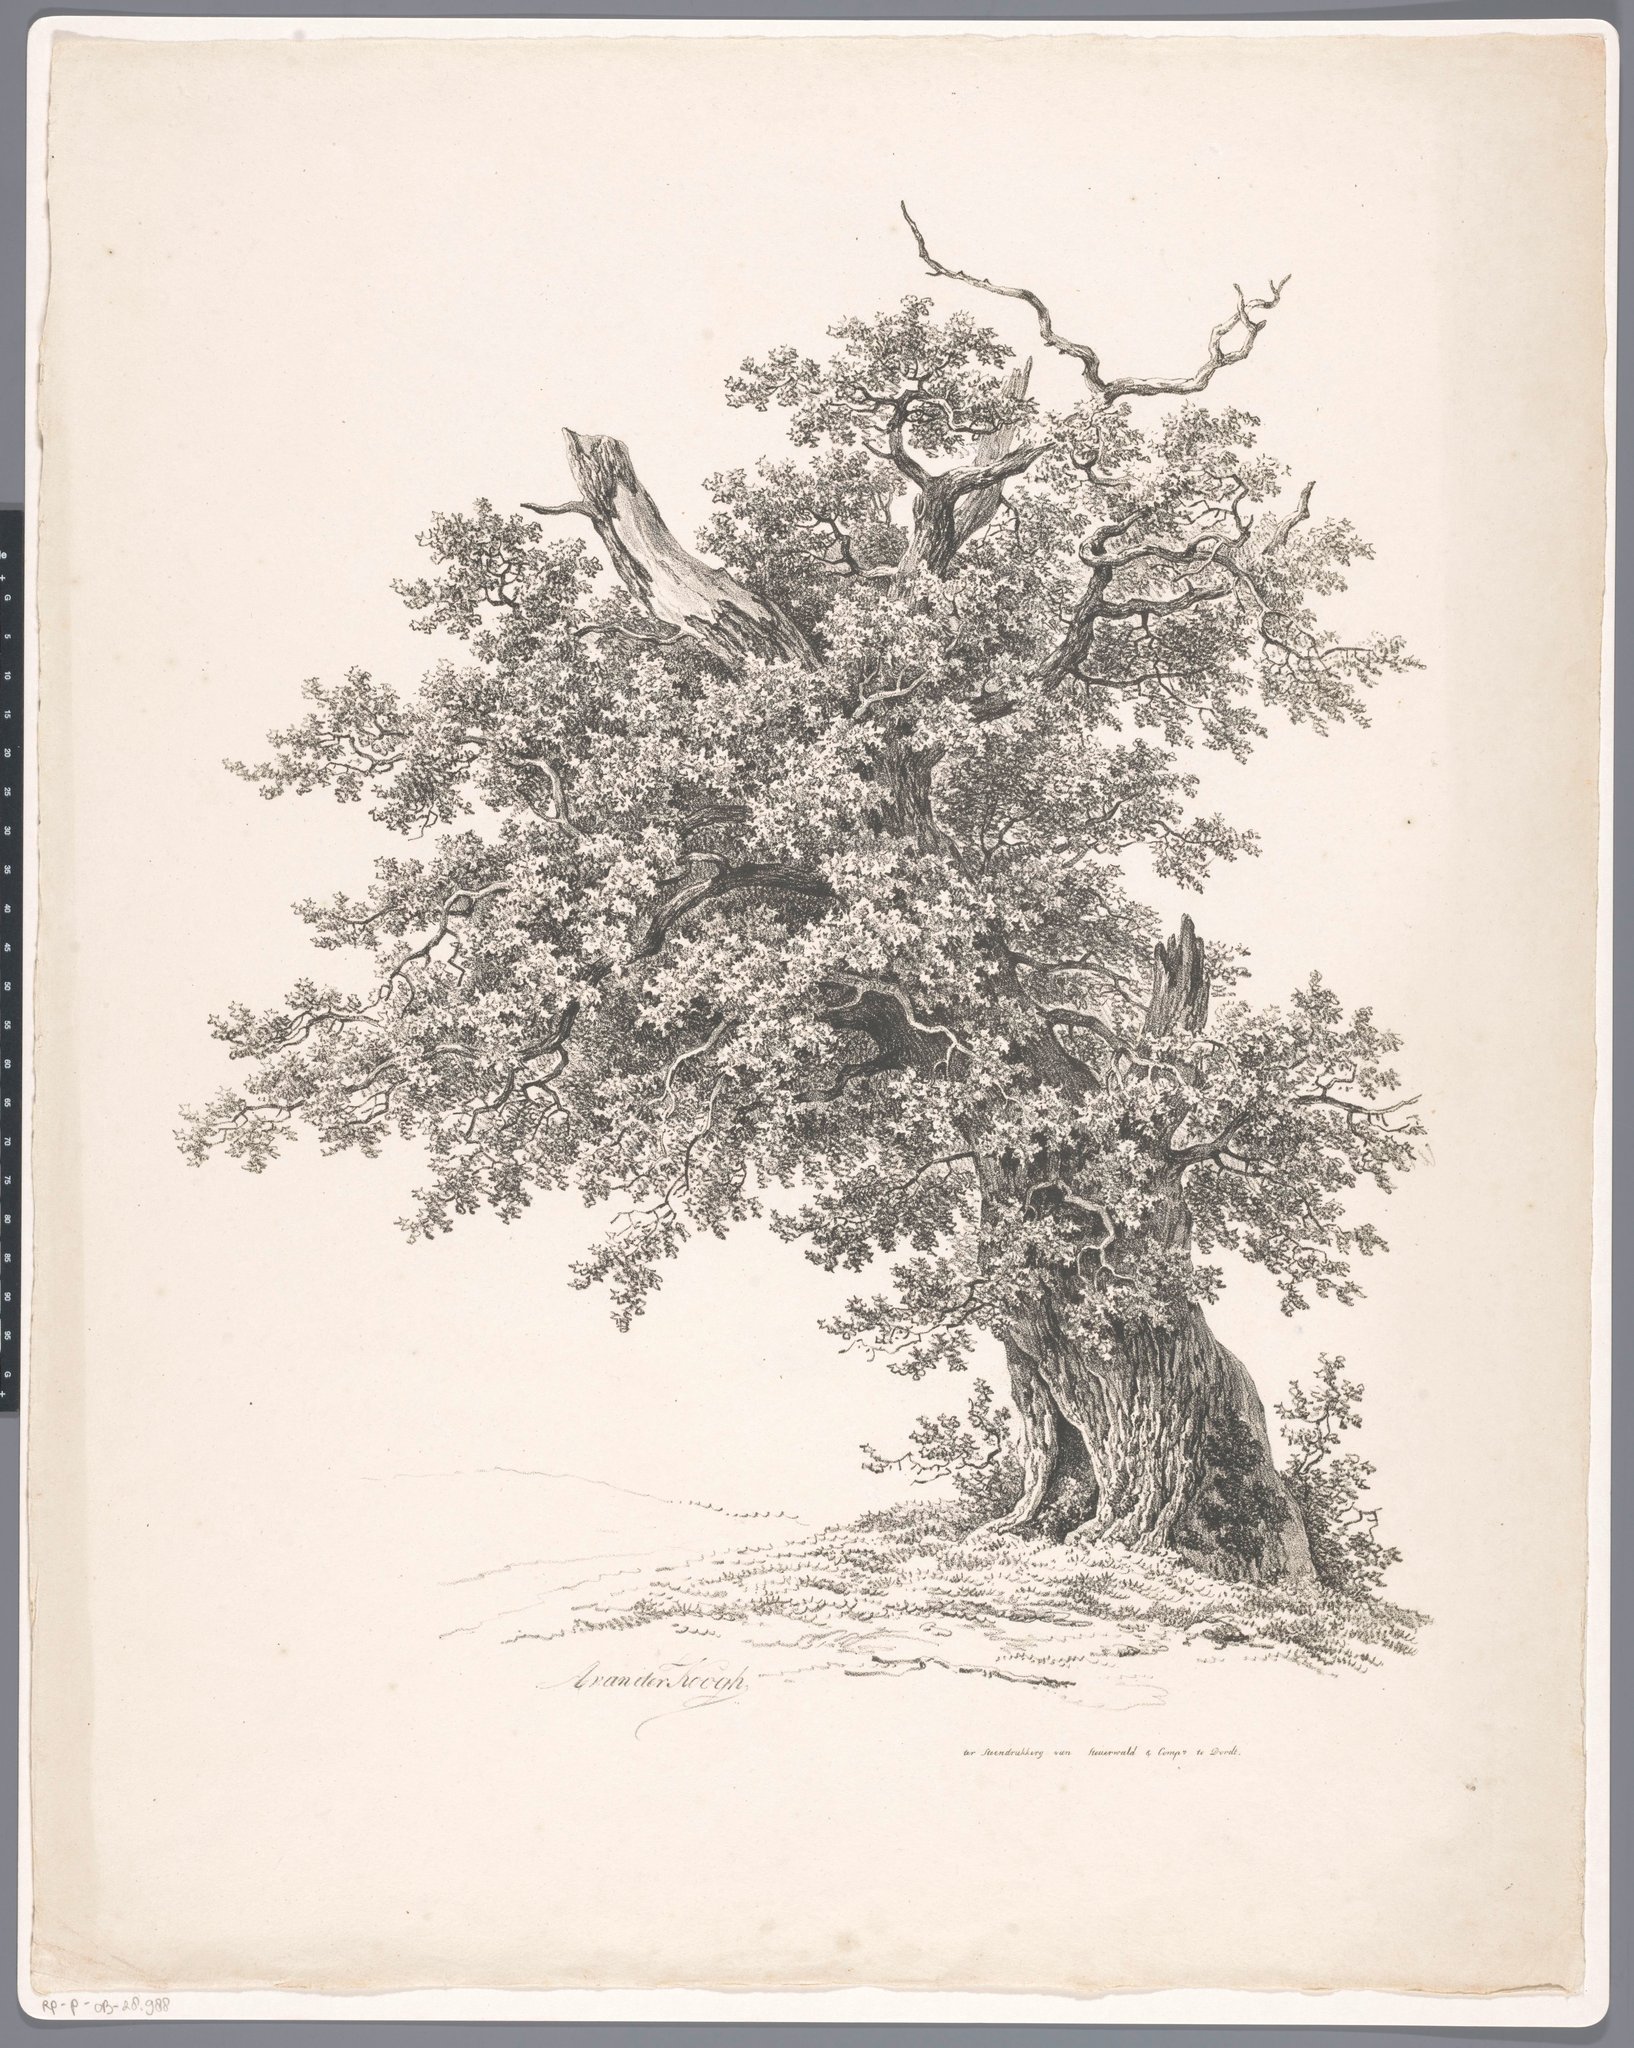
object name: print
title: Oude boom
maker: adrianus van der koogh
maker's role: draughtsman, print maker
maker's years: 1796-1831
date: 1826-1828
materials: paper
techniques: lithograph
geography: dordrecht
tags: trees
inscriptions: collector's mark: Lugt 2228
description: In 1826 gaf Steuerwald & Comp een serie boomstudies uit van Adrianus van der Koogh, bedoeld voor het tekenonderwijs. In de collectie van het Rijksmuseum bevinden zich de omslag voor deze eerste bundel uit 1826 (RP-P-OB-28.980) en de titelprent voor een tweede bundel uit 1828 (RP-P-OB-68.274). In de literatuur wordt enkel de uitgave in 1826 genoemd. Zie: Kramm, 1859.